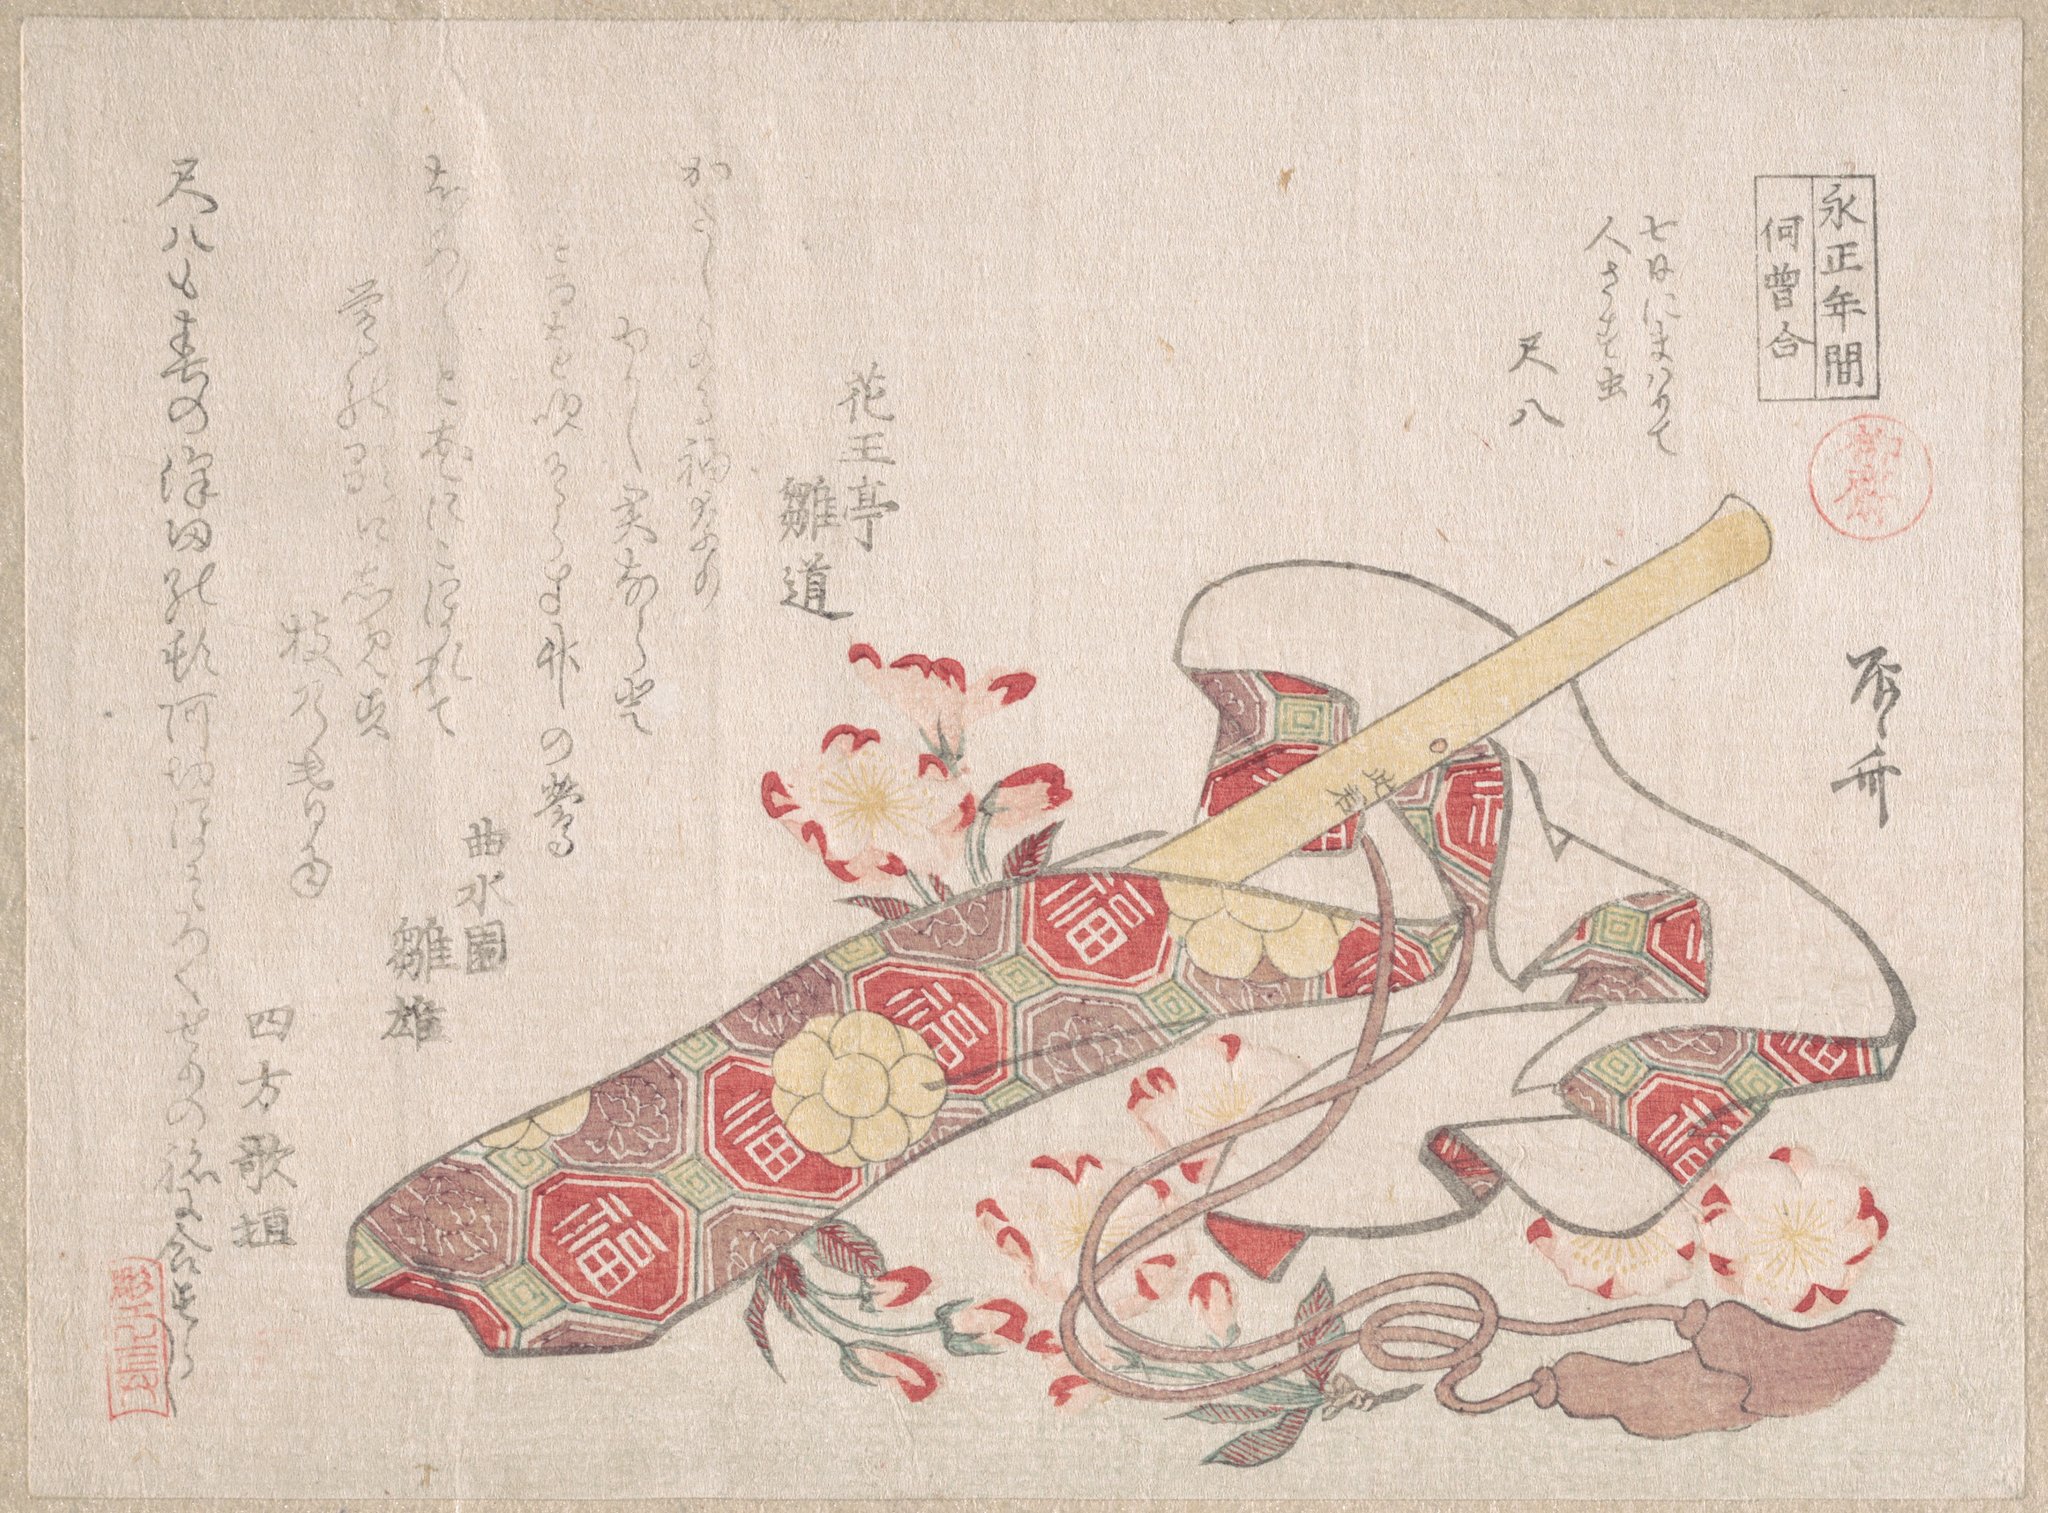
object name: print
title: Shakuhachi, (a kind of bamboo flute), with Its Cover and Cherry Flowers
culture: japanese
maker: ryūryūkyo shinsai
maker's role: artist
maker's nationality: japanese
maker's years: 1799-1823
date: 1801-1900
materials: ink, paper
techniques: surimono, woodblock print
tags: flutes,flowers